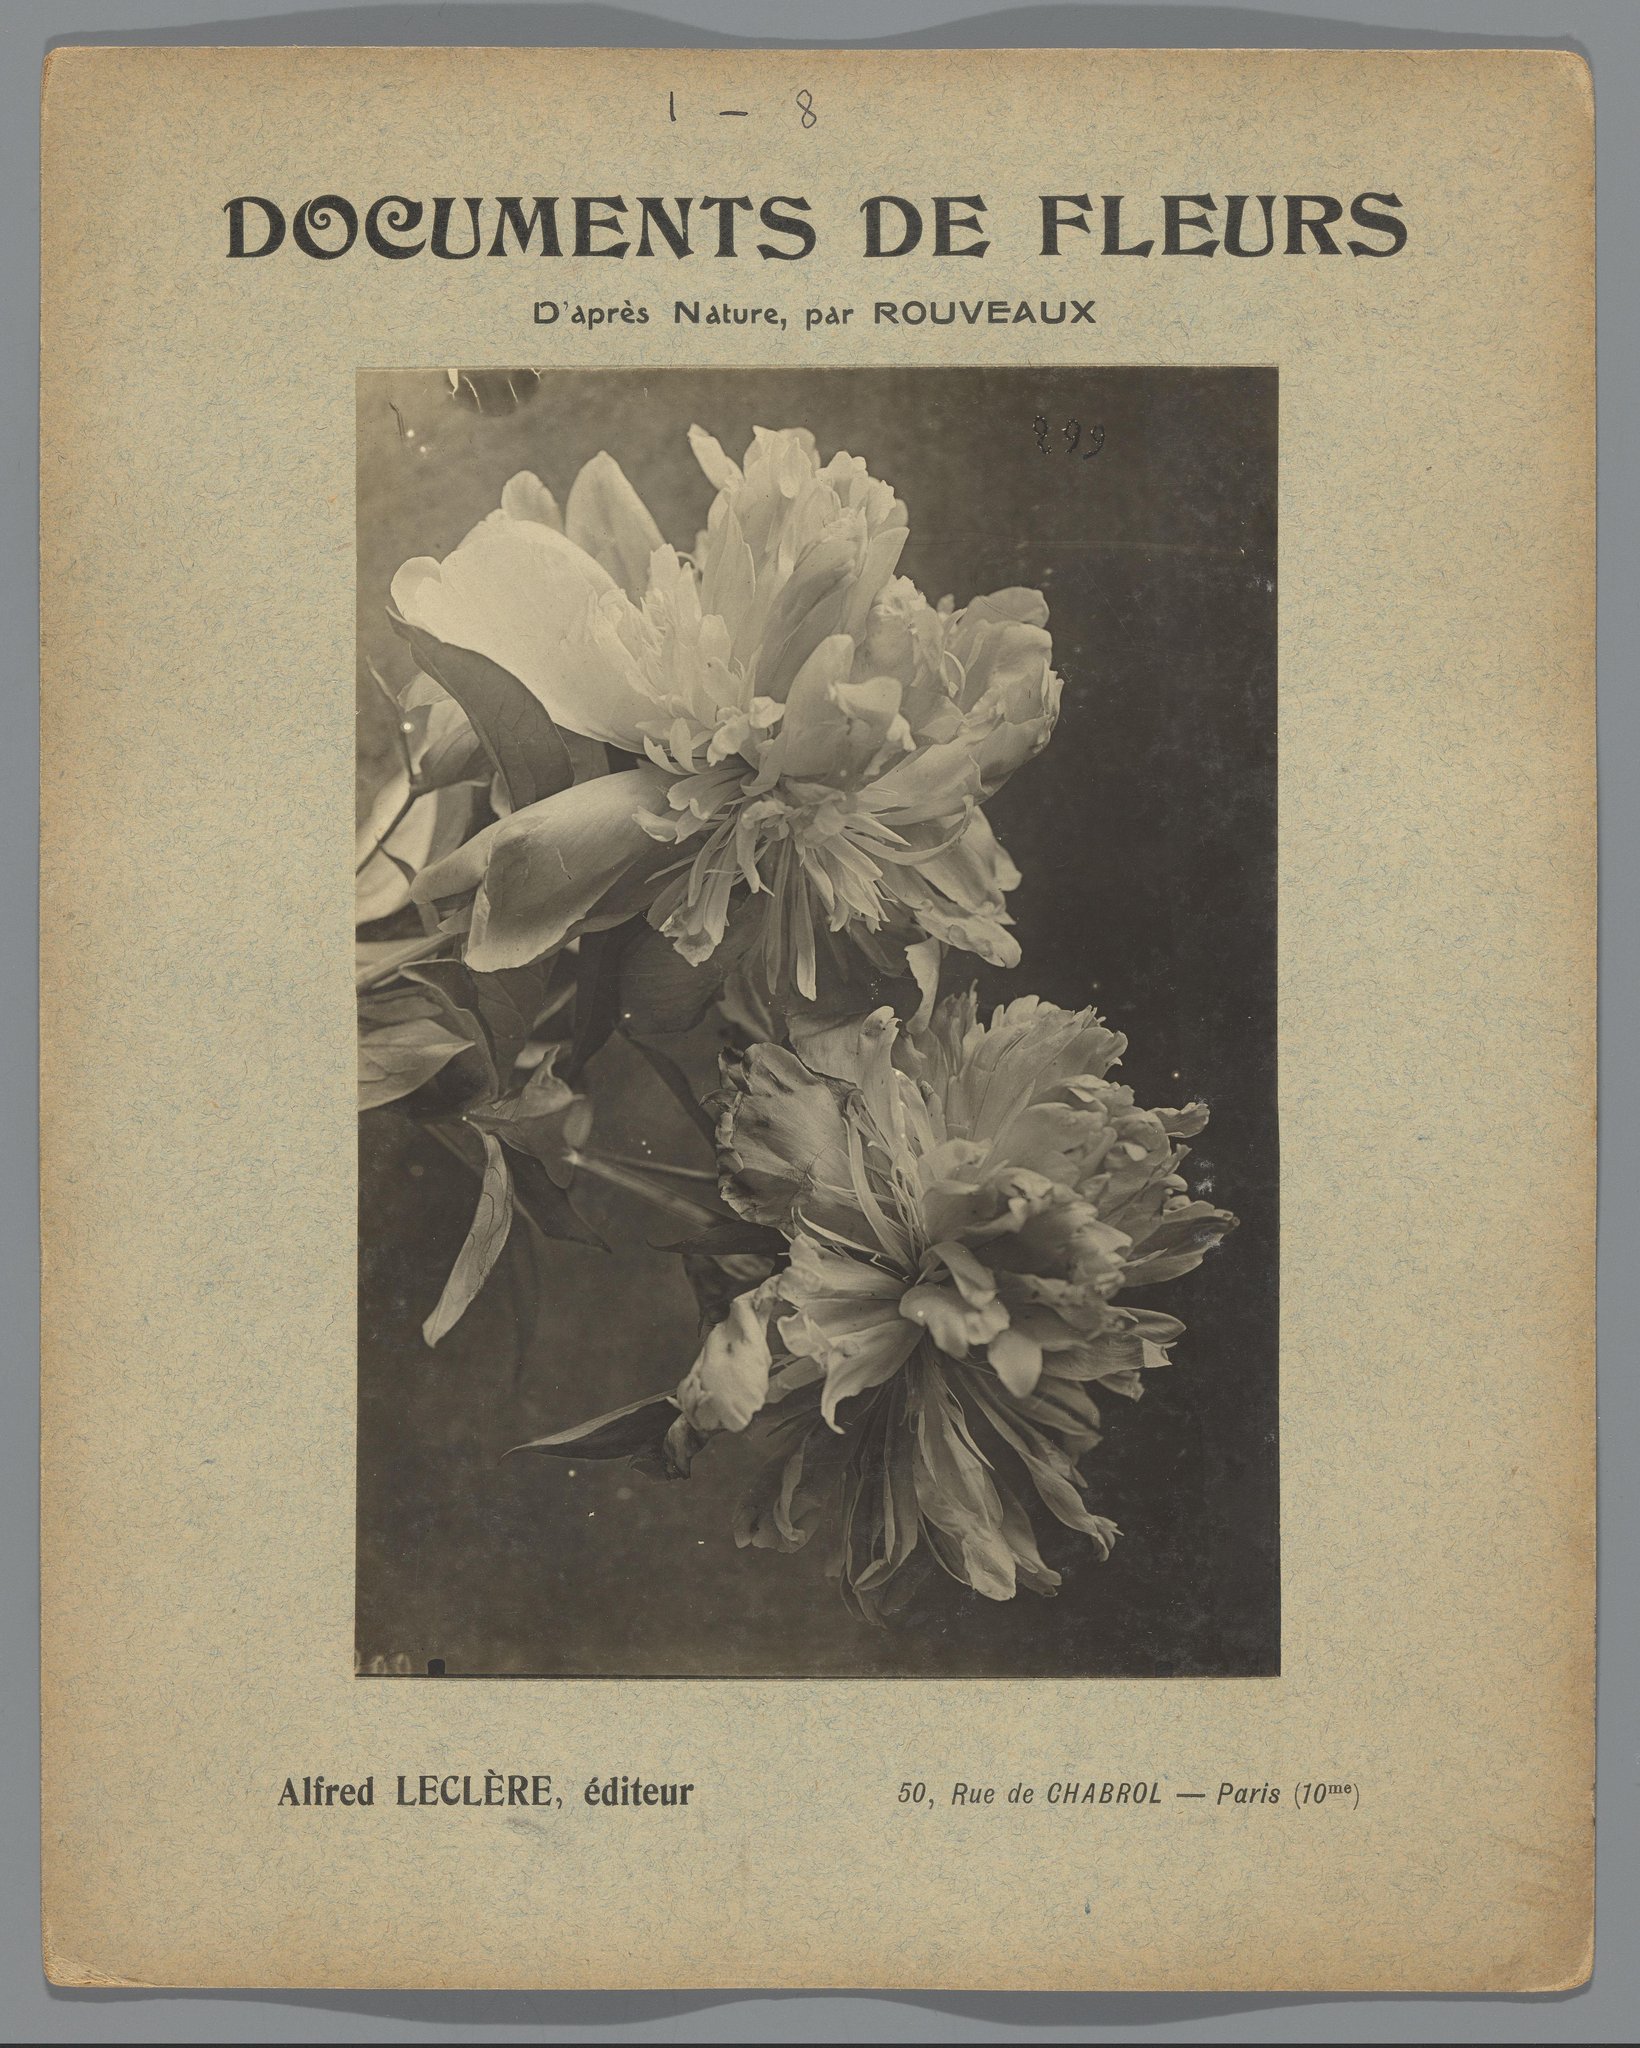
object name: photograph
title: Bloemstudie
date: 1895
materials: photographic support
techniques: gelatin silver print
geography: france